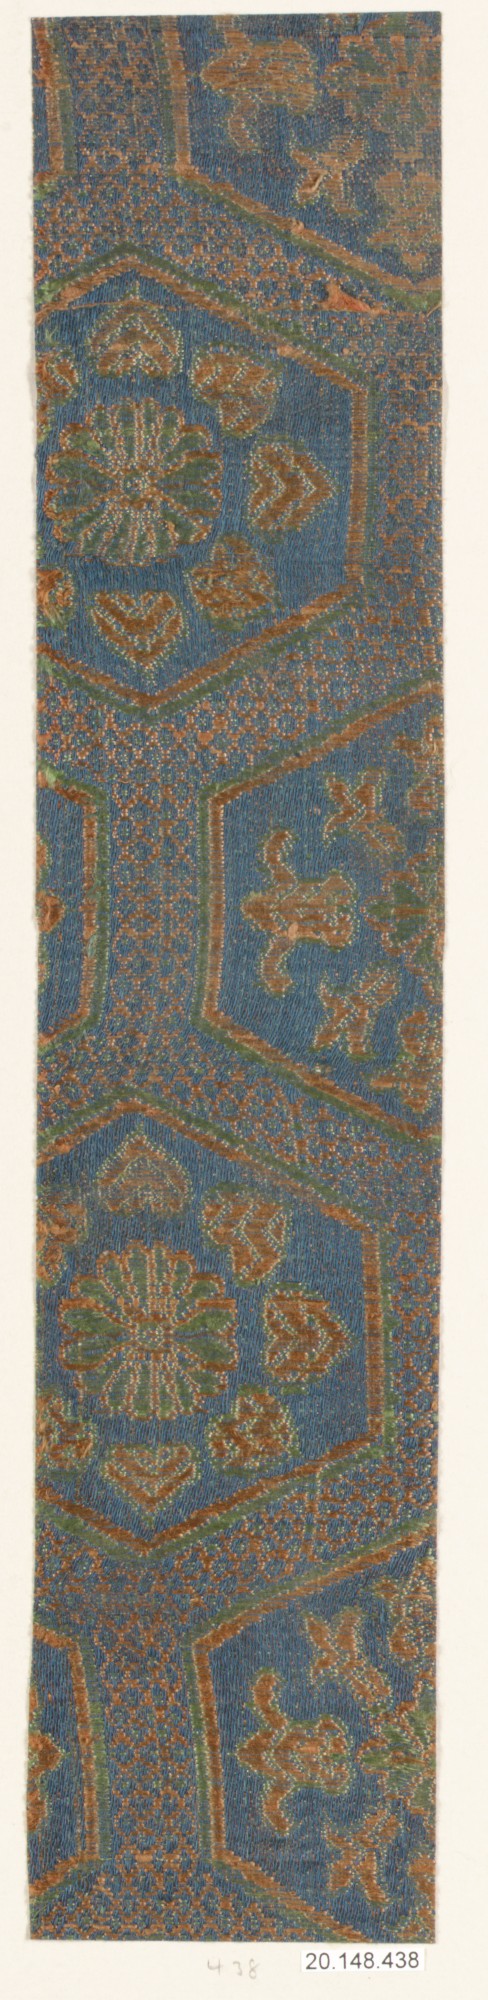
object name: piece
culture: chinese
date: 1701-1800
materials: silk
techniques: compound weave